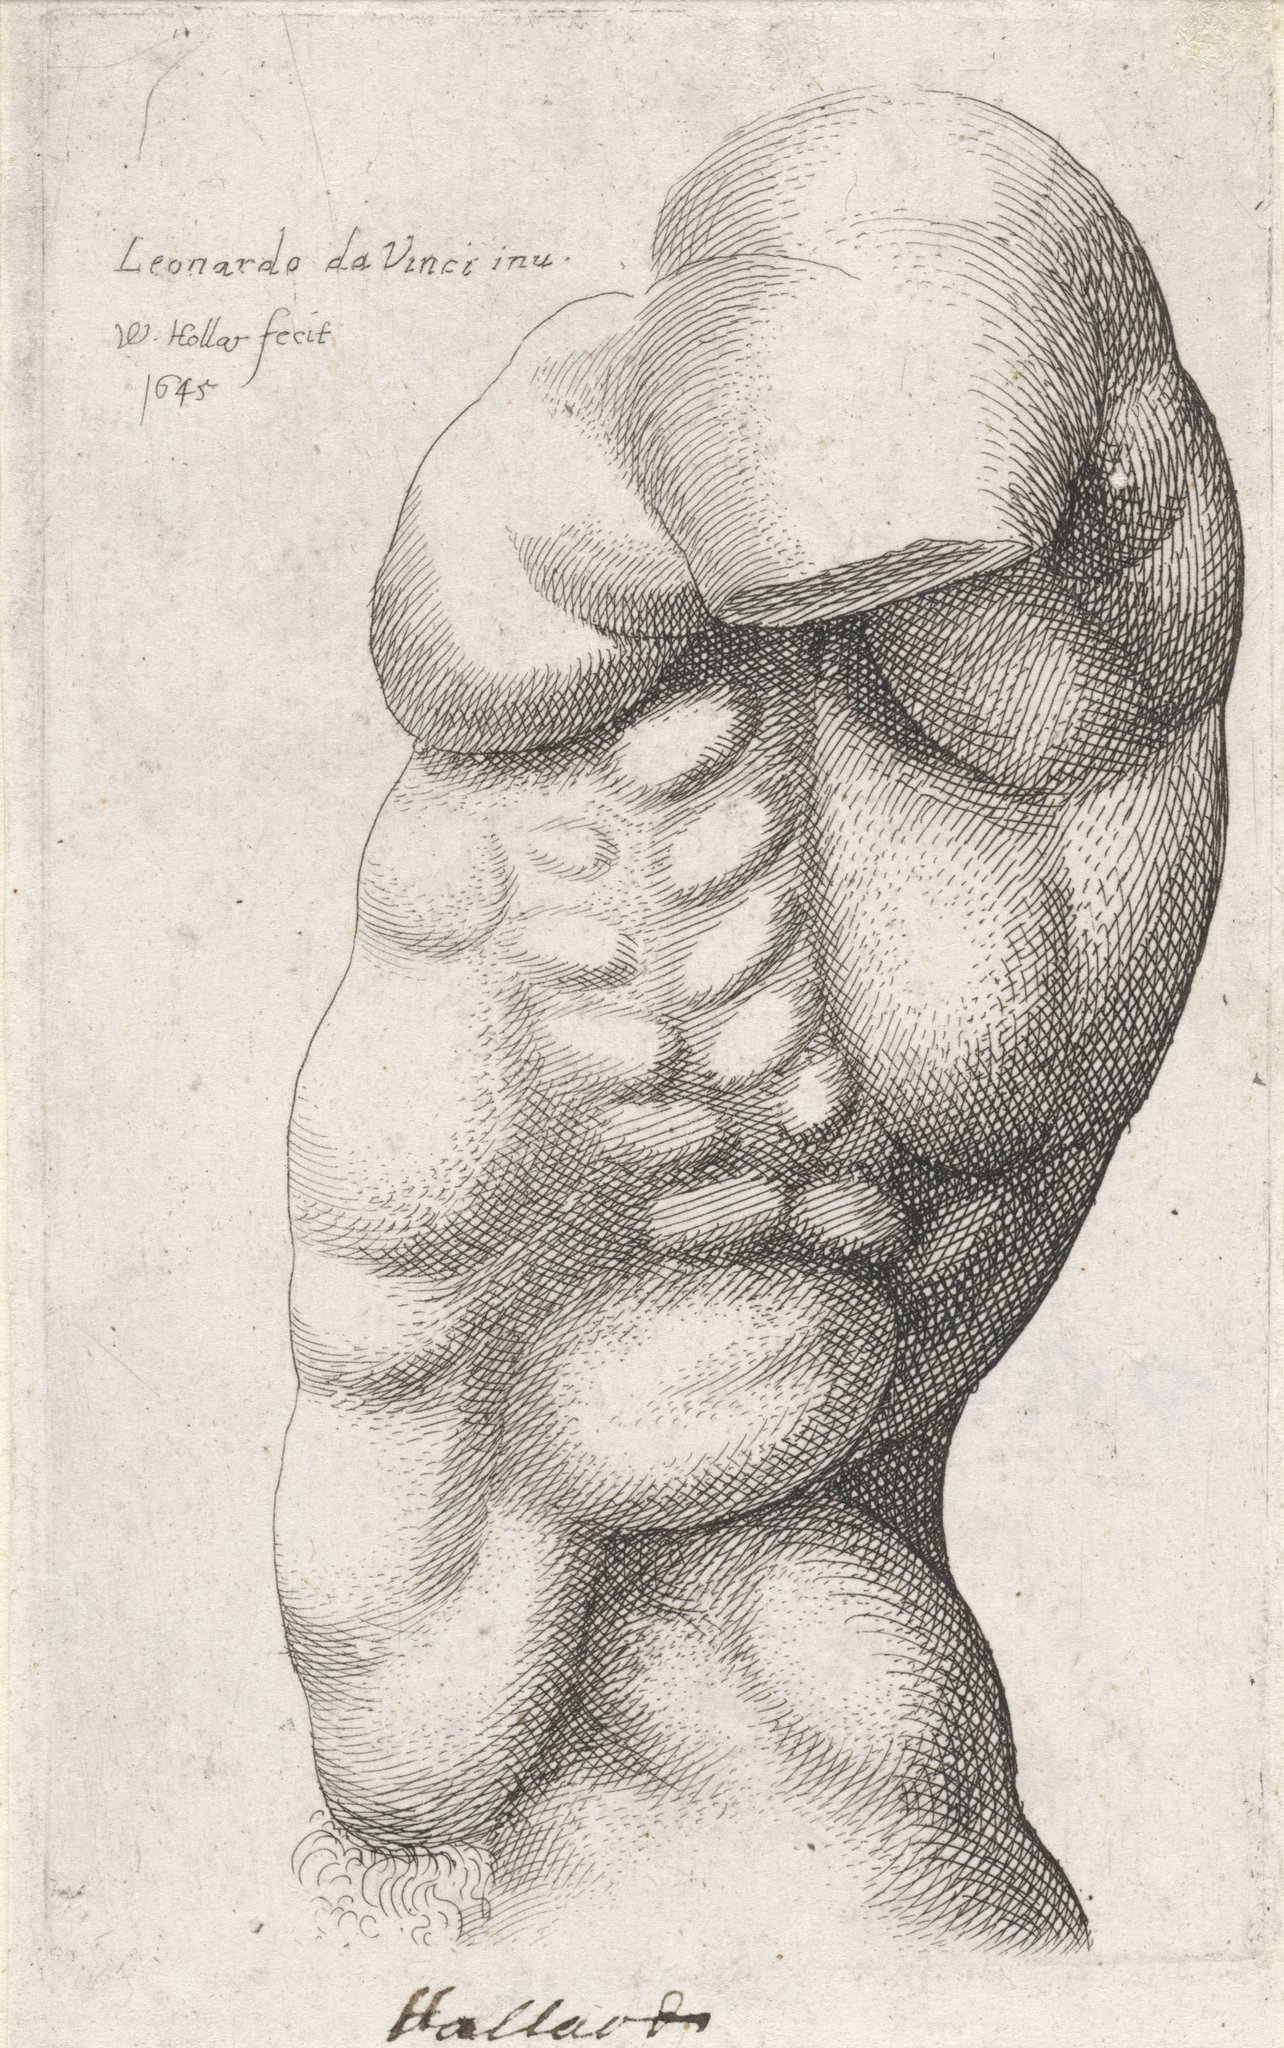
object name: print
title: Anatomische studie van de torso van een man, van opzij gezien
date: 1645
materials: paper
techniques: etching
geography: antwerp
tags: muscles, torso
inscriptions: inscription: ‘Hollar f’, collector's mark: Lugt 240